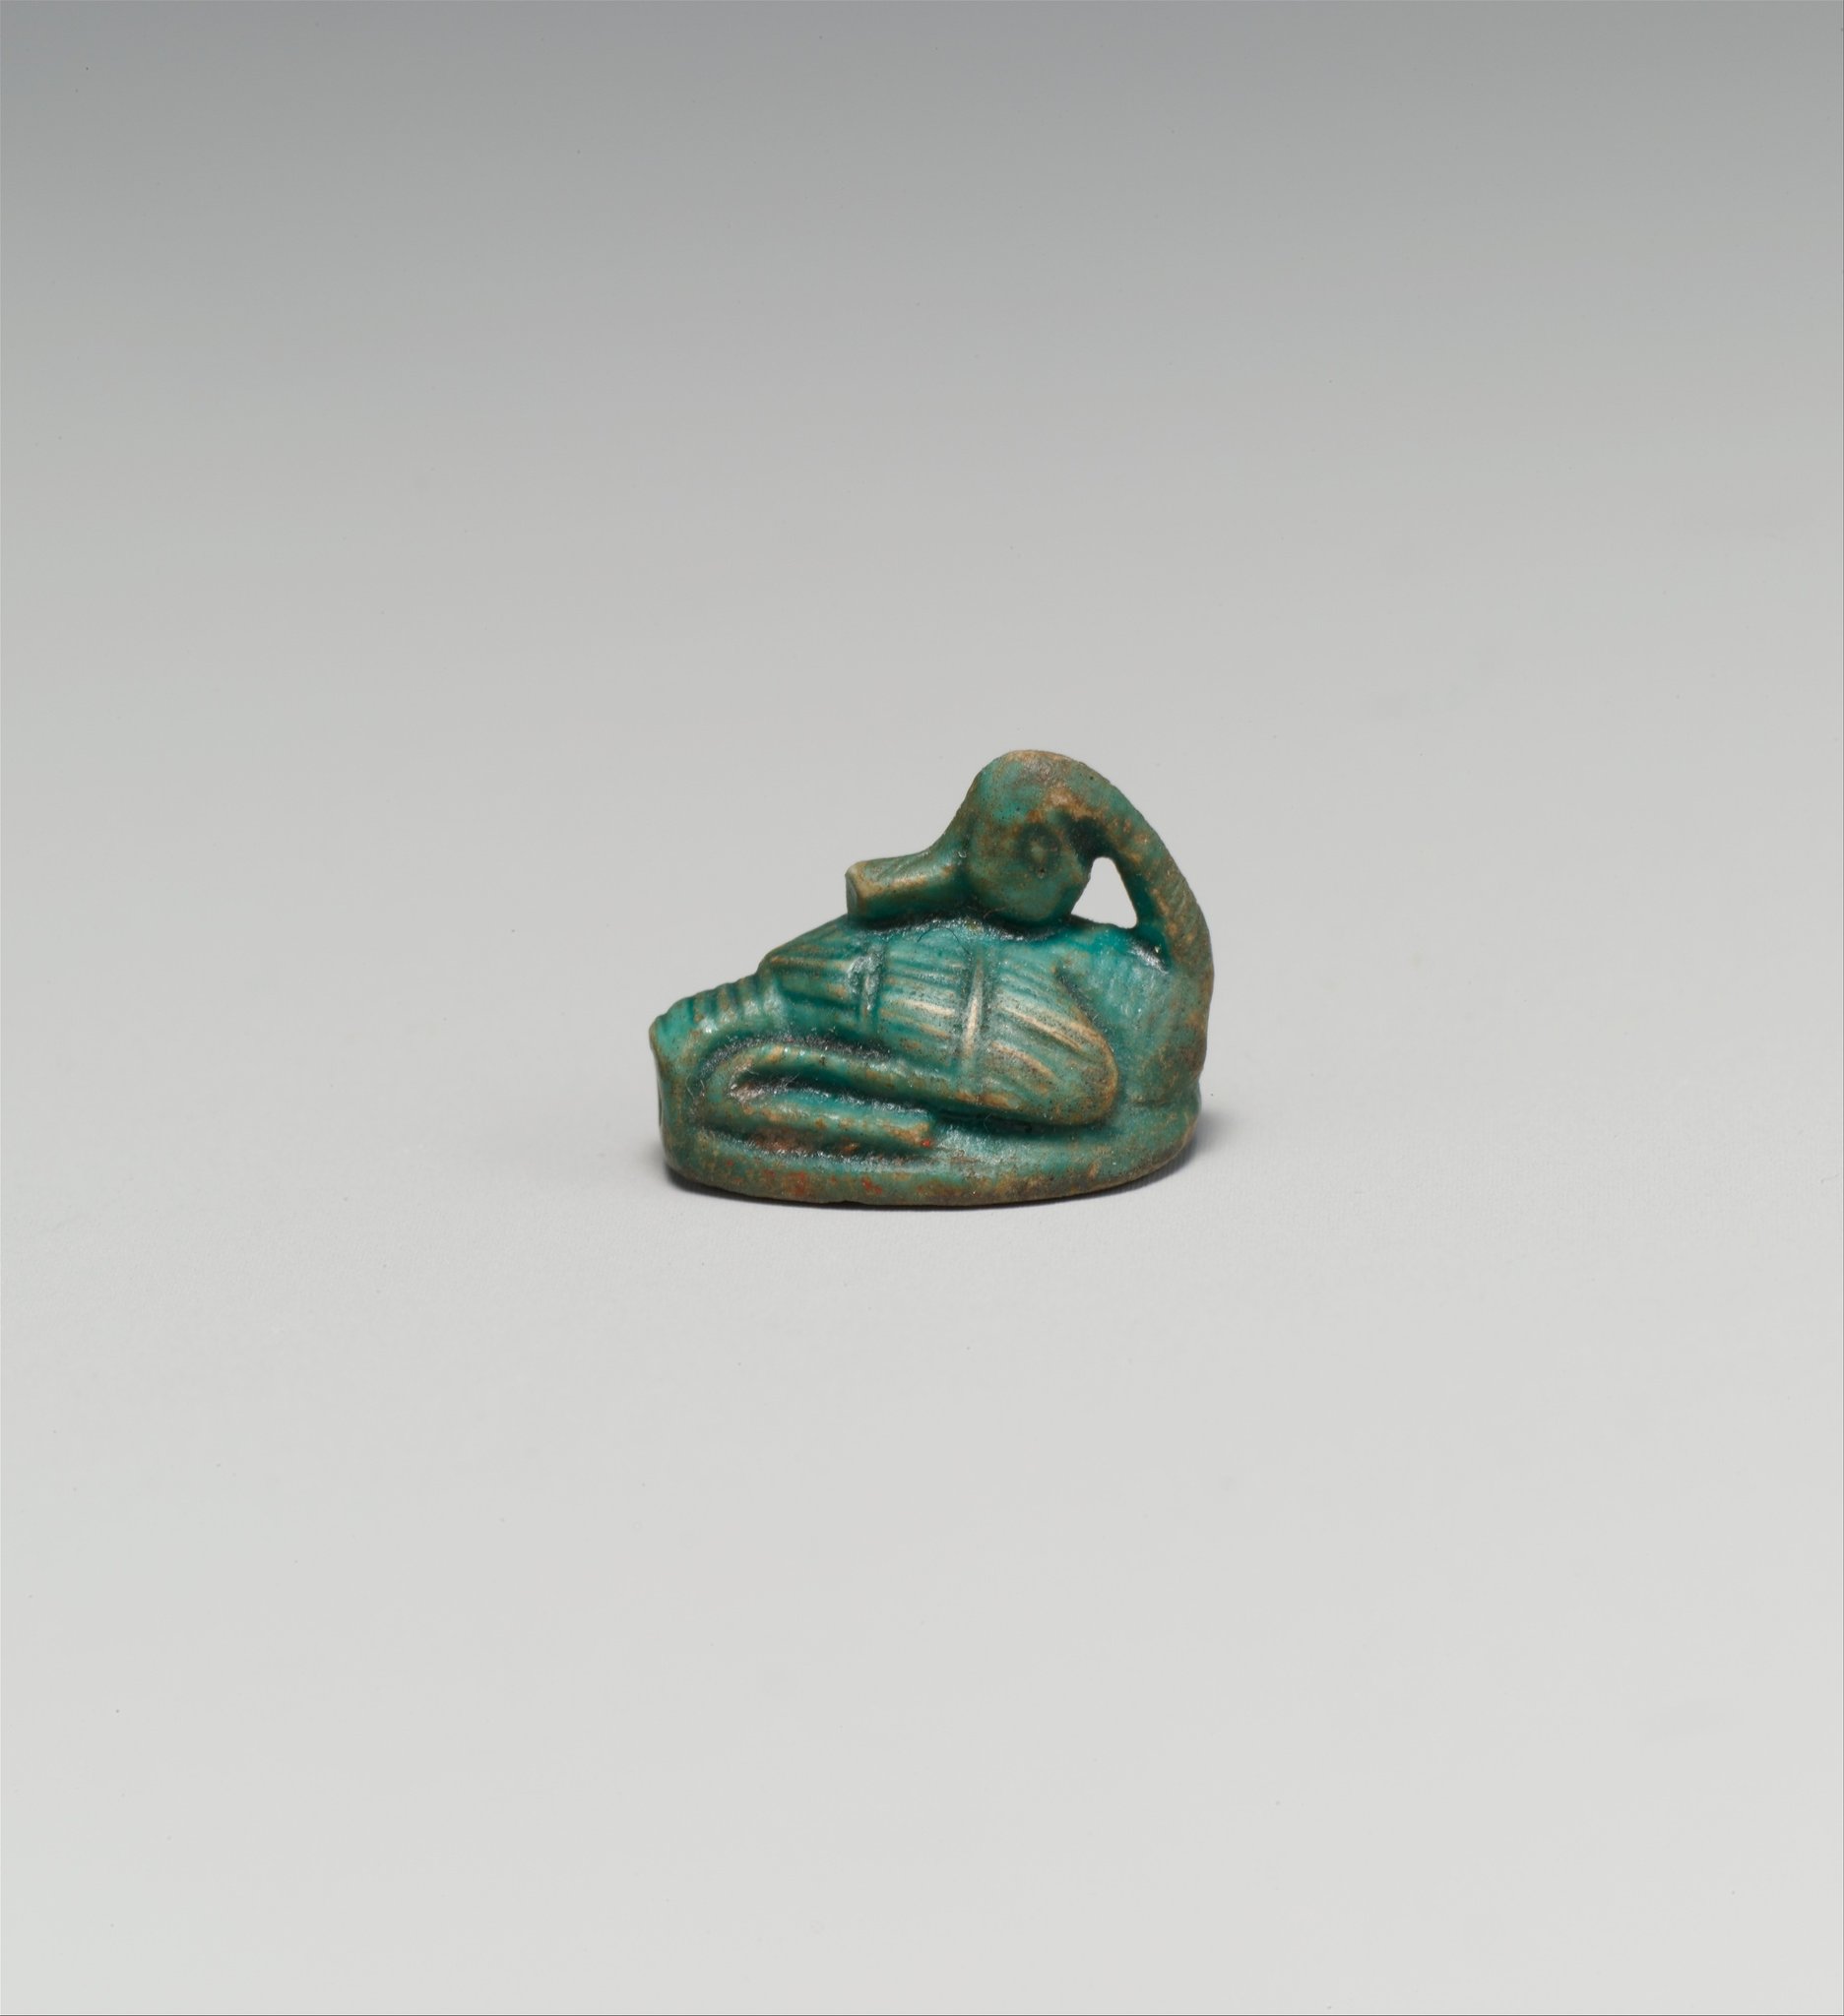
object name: amulet, duck, menkheperkare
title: Design amulet in the form of a duck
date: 1479-1425 BCE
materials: stone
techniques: glazing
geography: egypt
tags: ducks